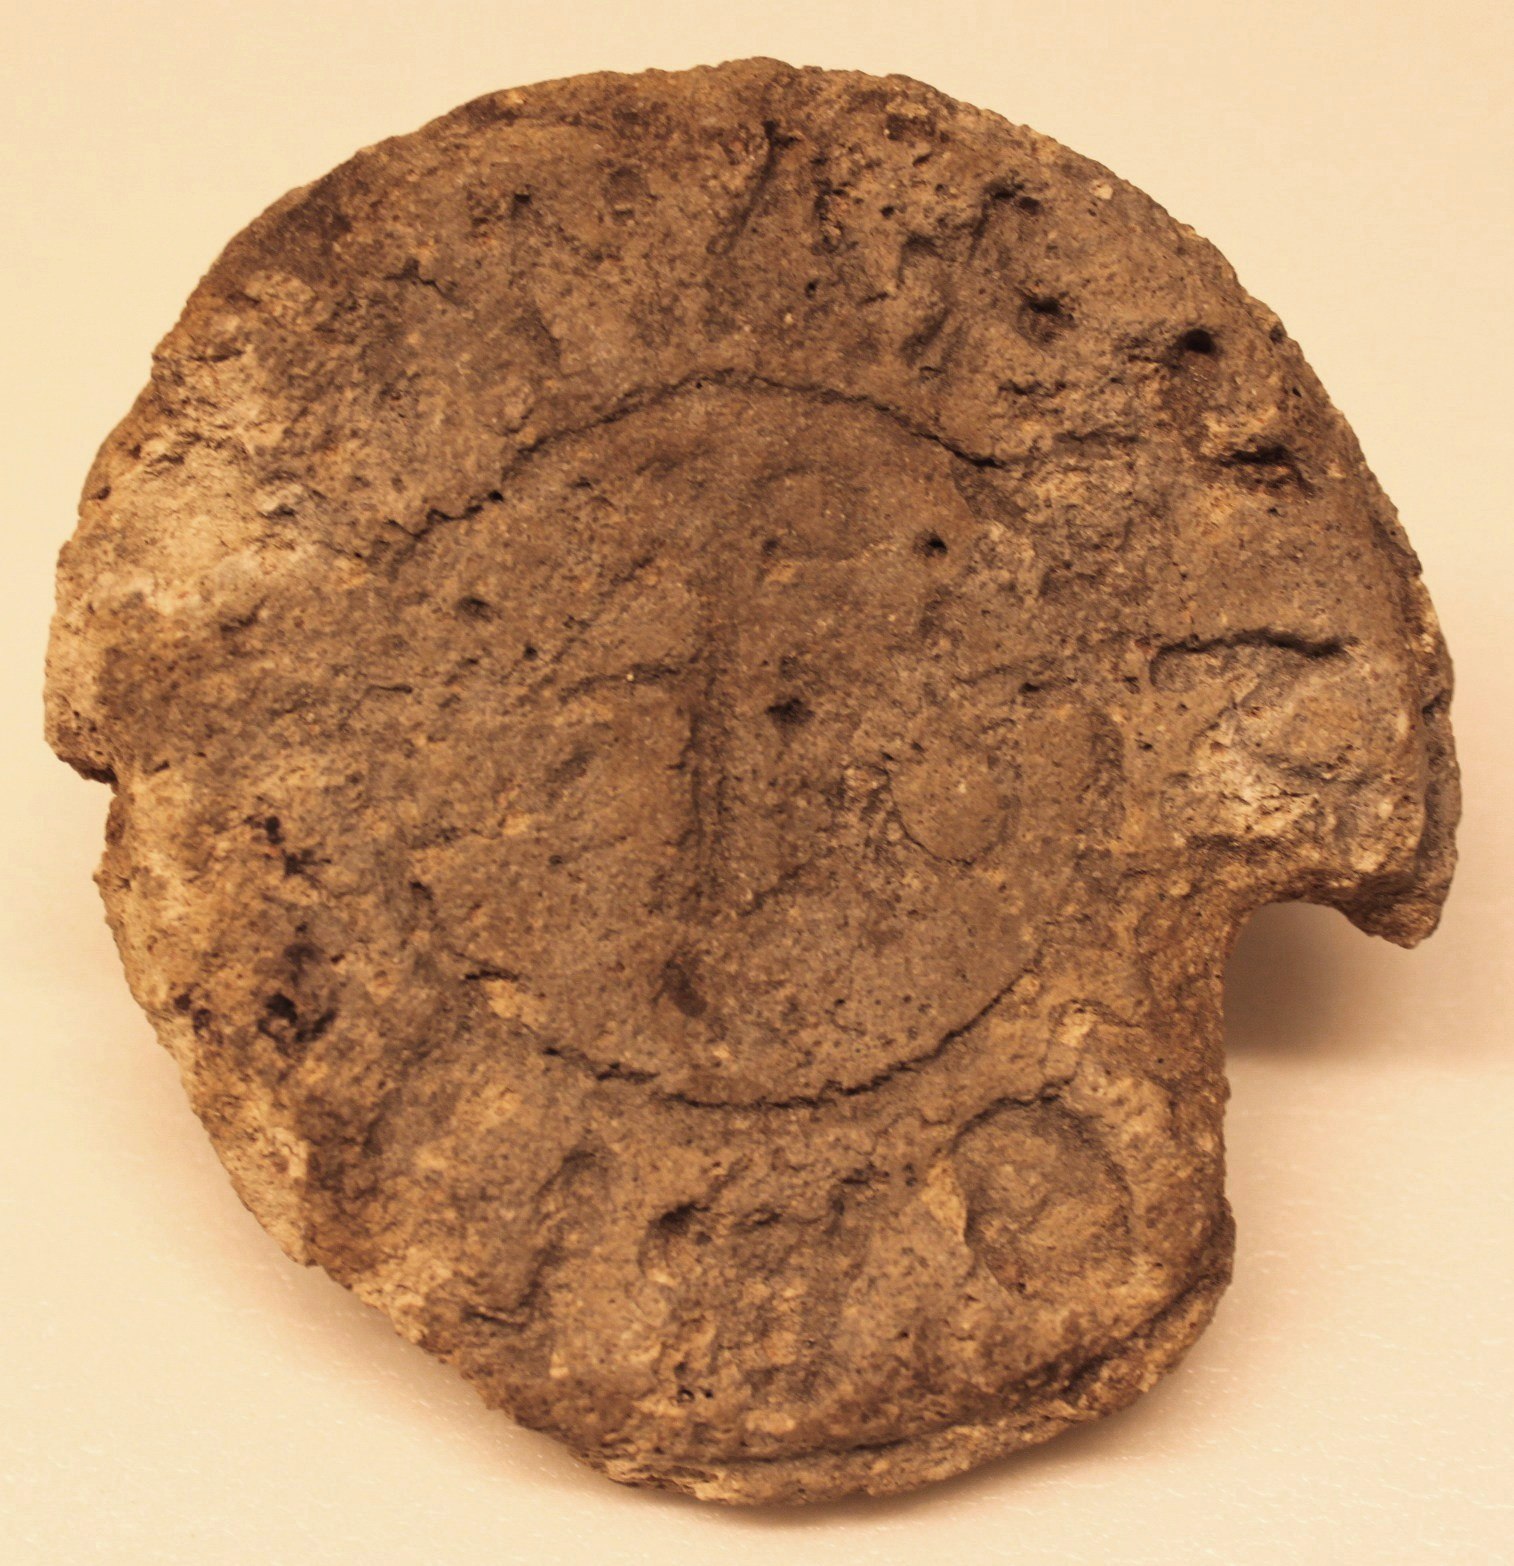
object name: seal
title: Seal for Jar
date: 501-700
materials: clay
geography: egypt